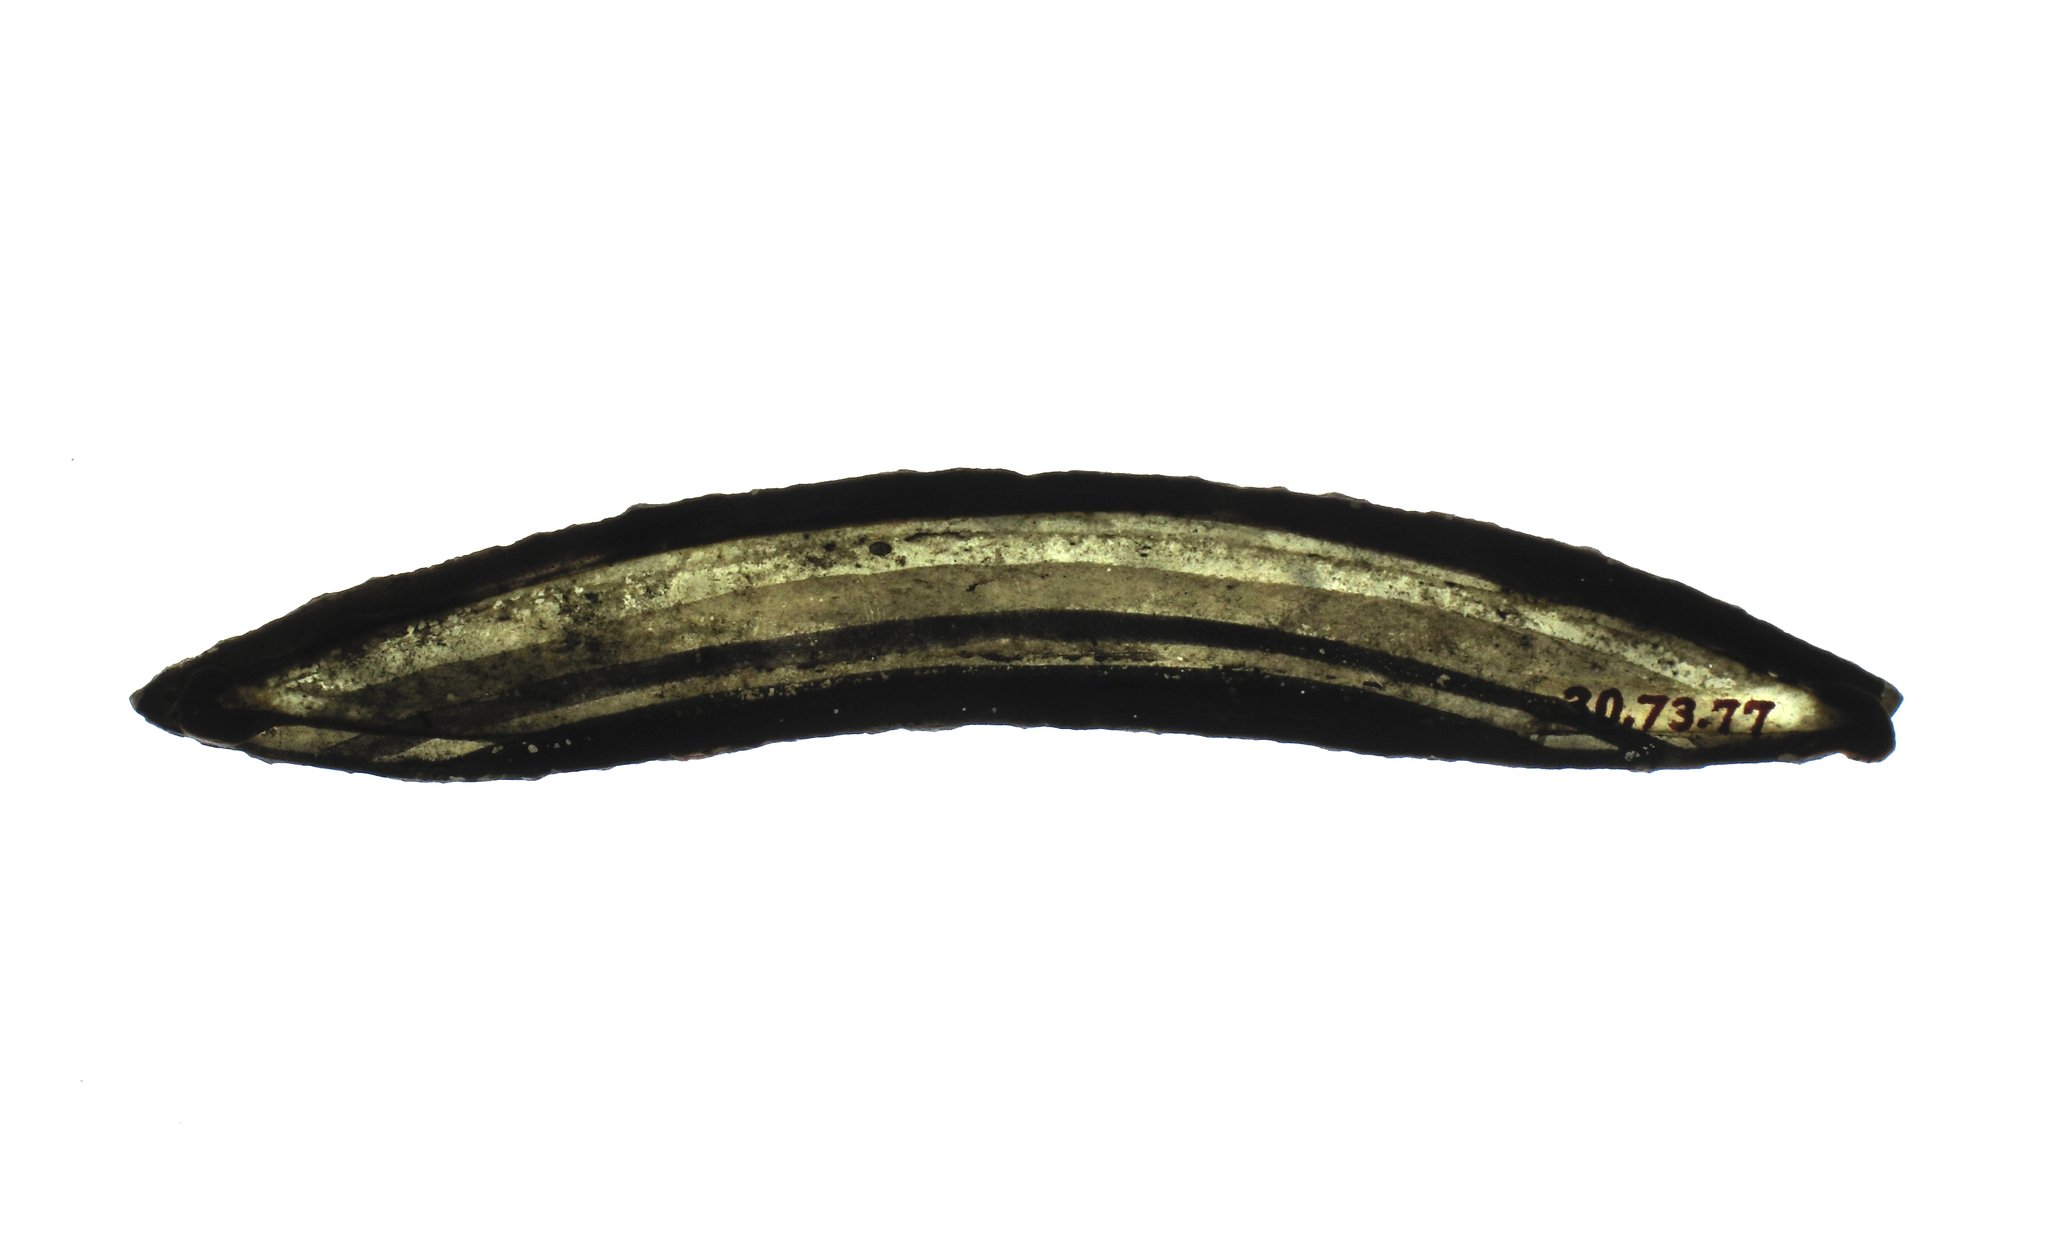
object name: fragment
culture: european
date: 1201-1500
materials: glass, metal, paint